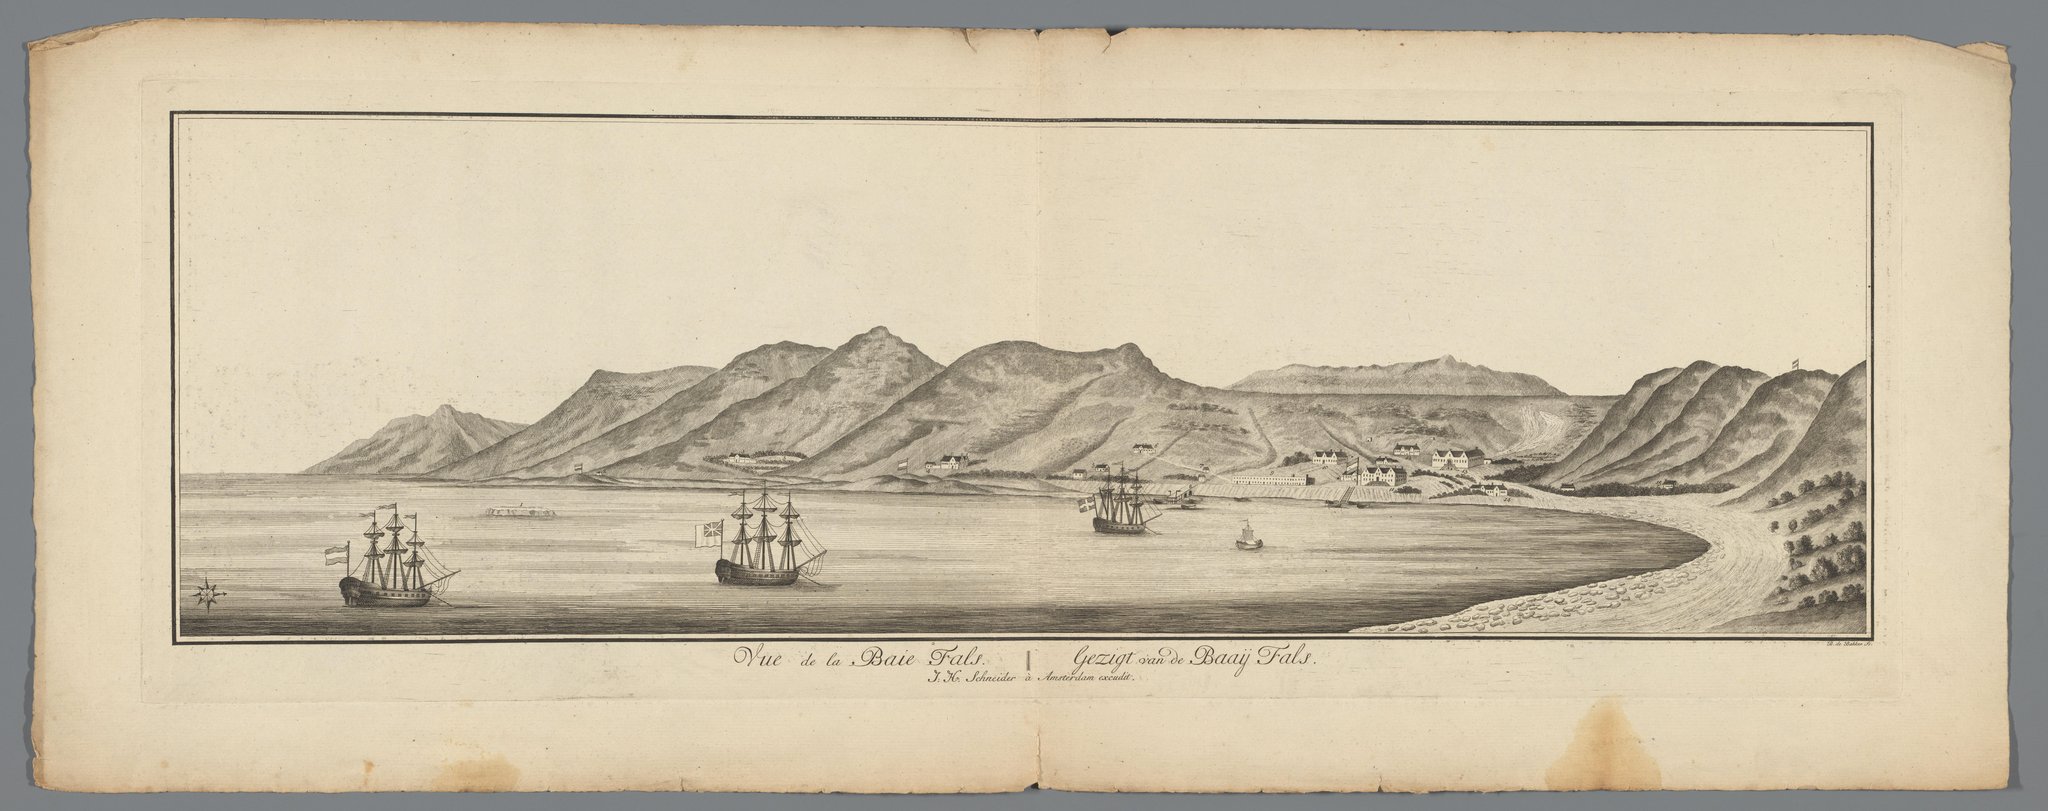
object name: print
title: Gezicht op Valsbaai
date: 1777-1785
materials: paper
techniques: etching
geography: netherlands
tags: gulf, bay, sailing-ship, sailing-boat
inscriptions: label: ‘B12’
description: Panorama van de Simonsbaai, het westelijke deel van de Valsbaai. In de baai een Nederlands, Engels en Zweeds schip. Naar de tekening in twee delen door Schumacher.